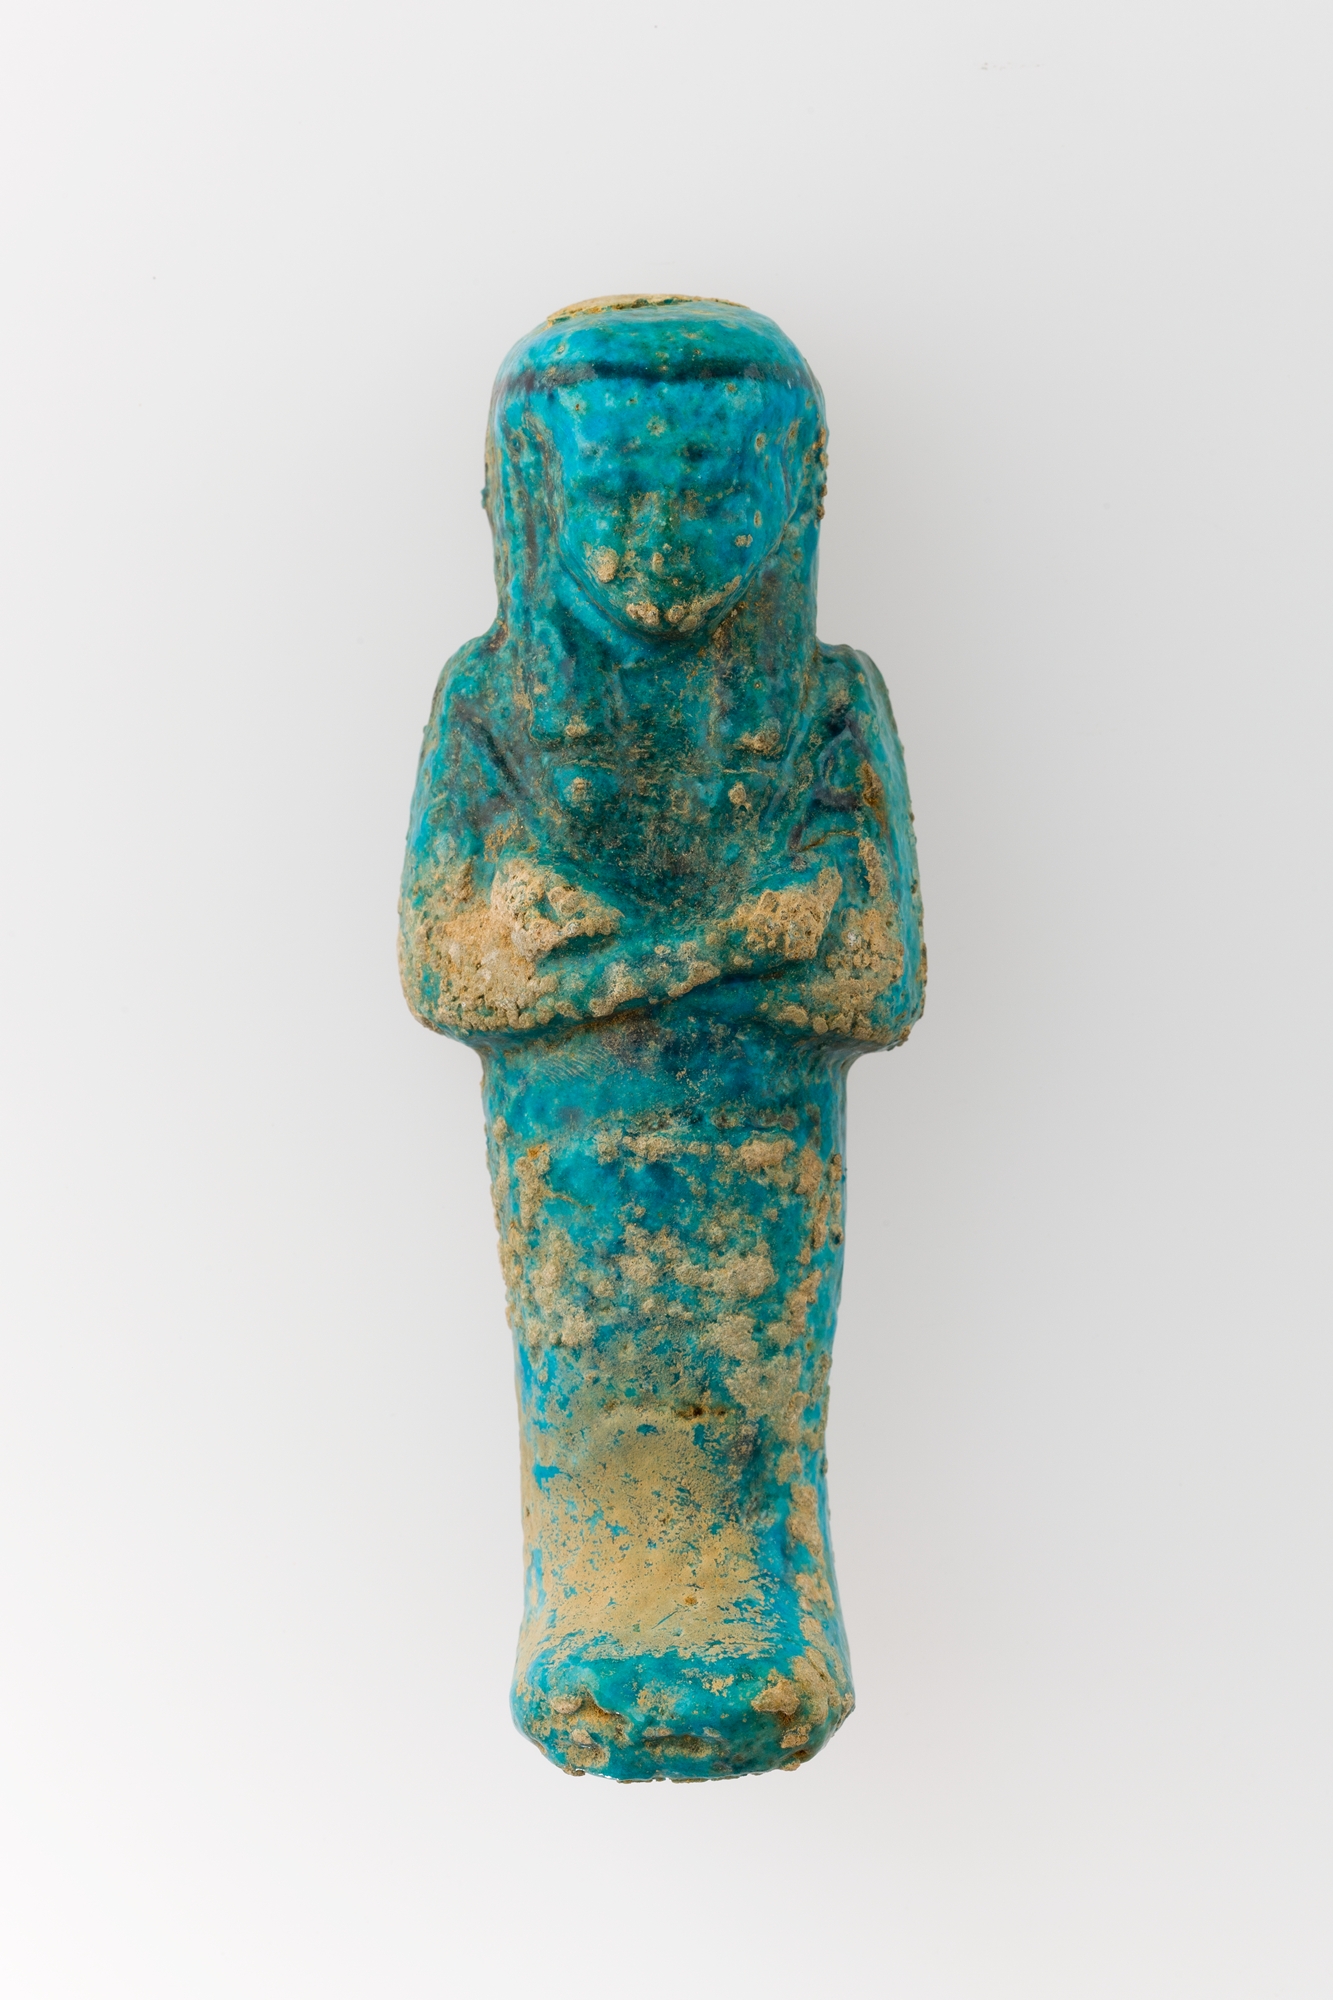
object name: shabti, henettawy c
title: Worker Shabti of Henettawy (C), Daughter of Isetemkheb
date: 990-970 BCE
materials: faience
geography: egypt